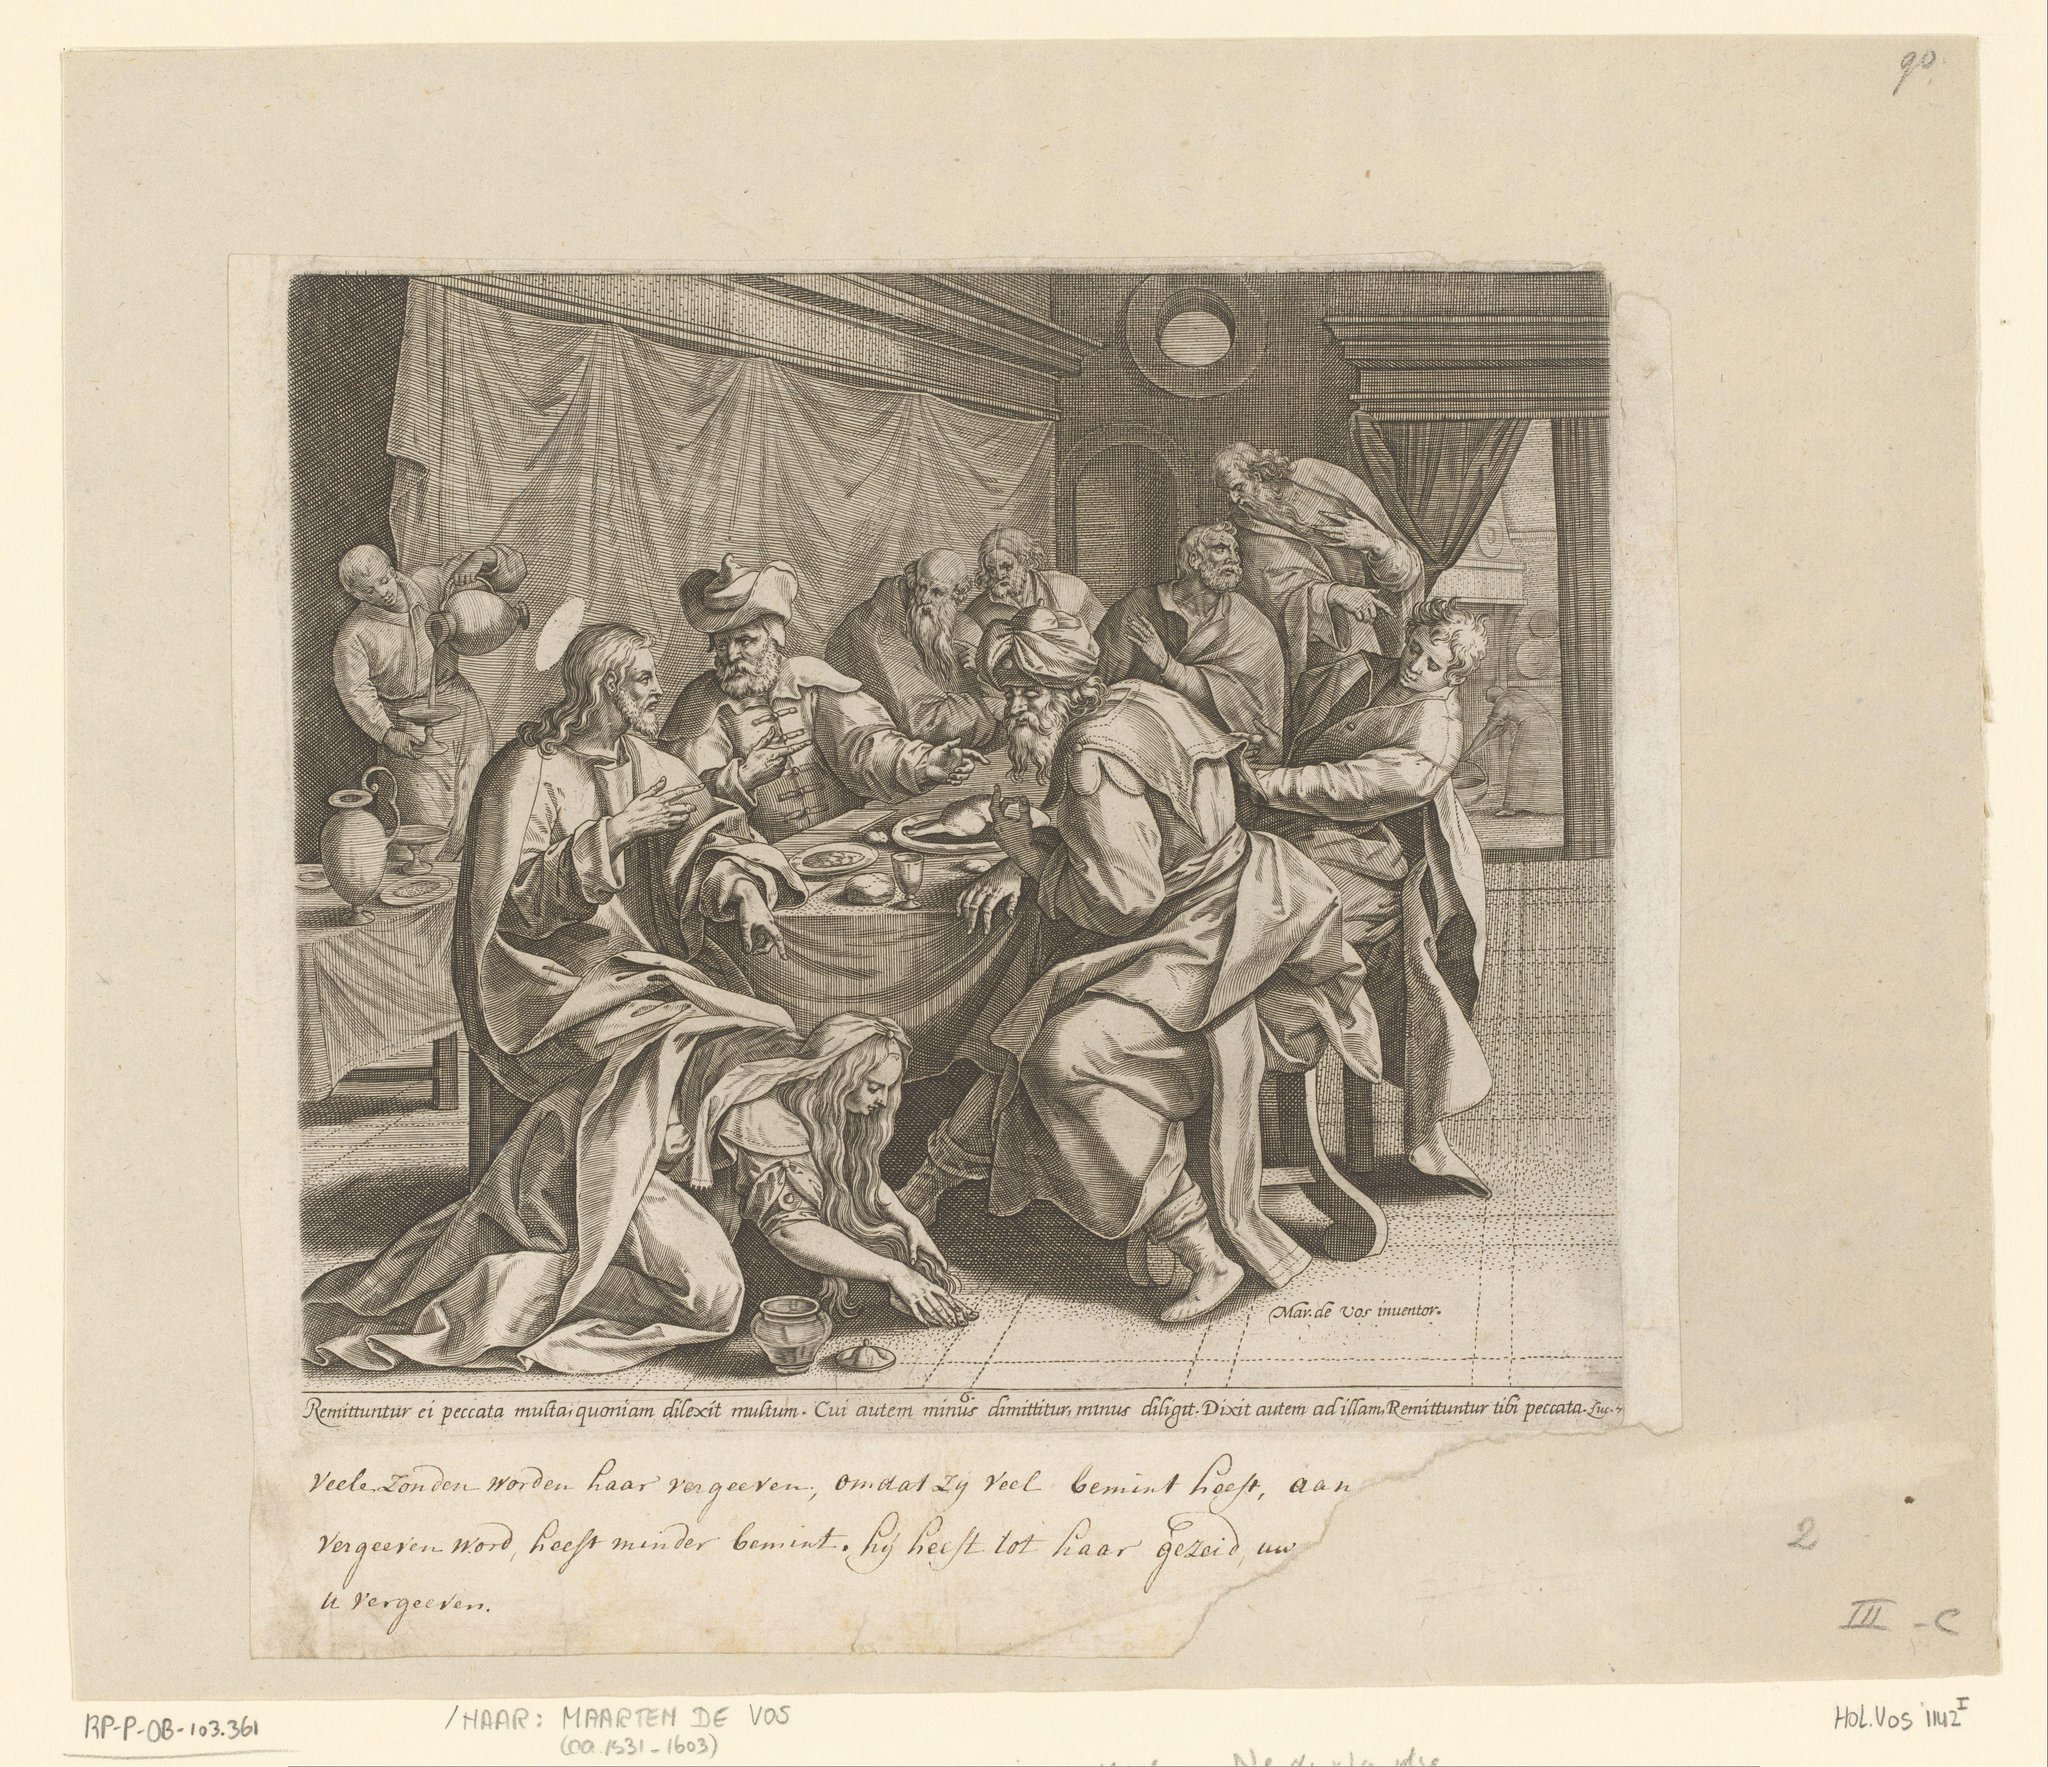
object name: print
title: Maria Magdalena wast de voeten van Christus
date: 1547-1612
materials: paper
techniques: engraving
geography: antwerp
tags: a woman washes christ's feet with her tears, and wipes them with her hair, christ's feet are anointed by mary (magdalene)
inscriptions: collector's mark: Lugt 2228, inscription: ‘Veel zonden worden haar vergeeven, omdat zij veel bemint heeft, [...] vergeeven word, heeft minder bemint. hij heeft tot haar gezeid uw [...] u vergeeven.’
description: In het huis van Simon wast een zondige vrouw (Maria Magdalena) de voeten van Christus met haar tranen en droogt zij ze met haar haren. Christus vergeeft haar zonden. De prent heeft een Latijns en (handgeschreven) Nederlands onderschrift.